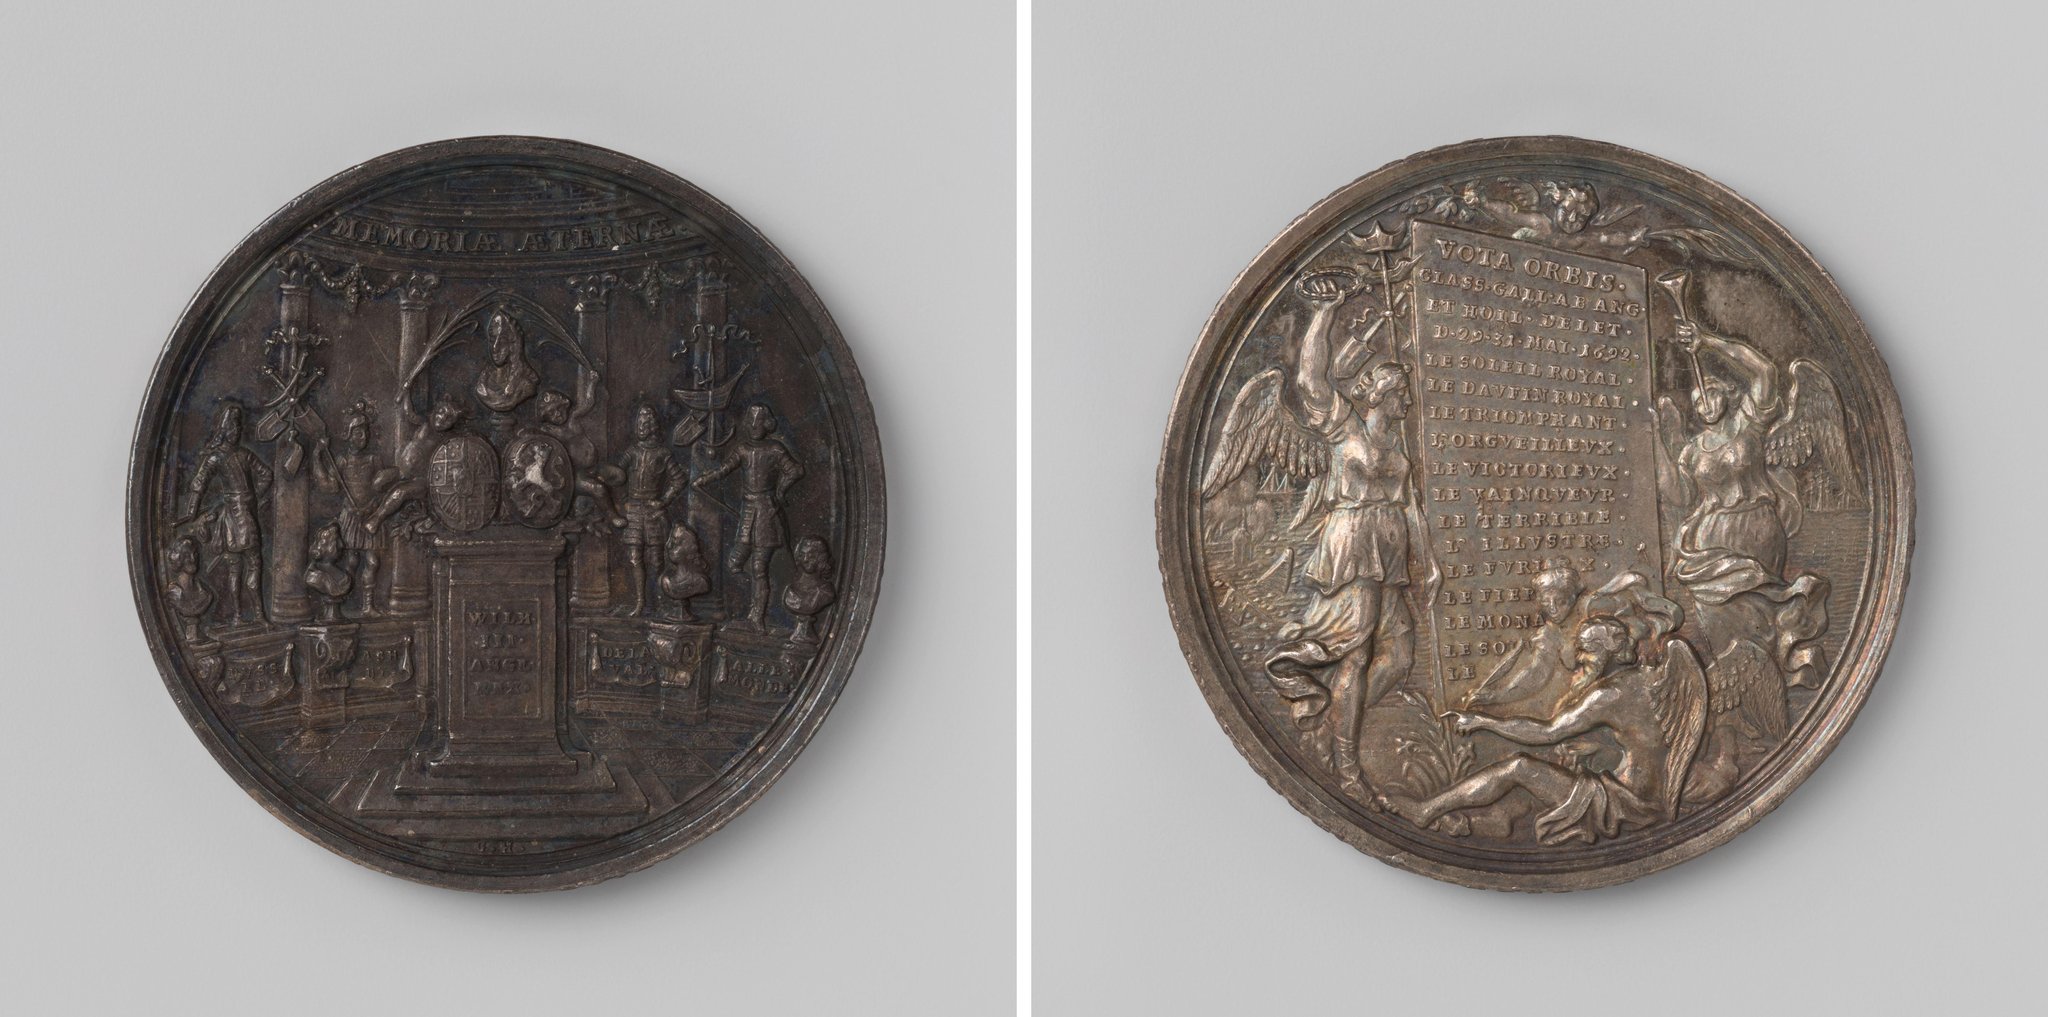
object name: history medal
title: Zeeslag bij Kaap La Hogue, ter ere van Willem III, Russell, van Almonde, Aschby en Delaval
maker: georg hautsch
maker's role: medailleur, muntmaker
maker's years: 1679-1745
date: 1692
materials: silver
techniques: striking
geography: nuremberg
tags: william iii (prince of orange and king of england, scotland, and ireland), politician